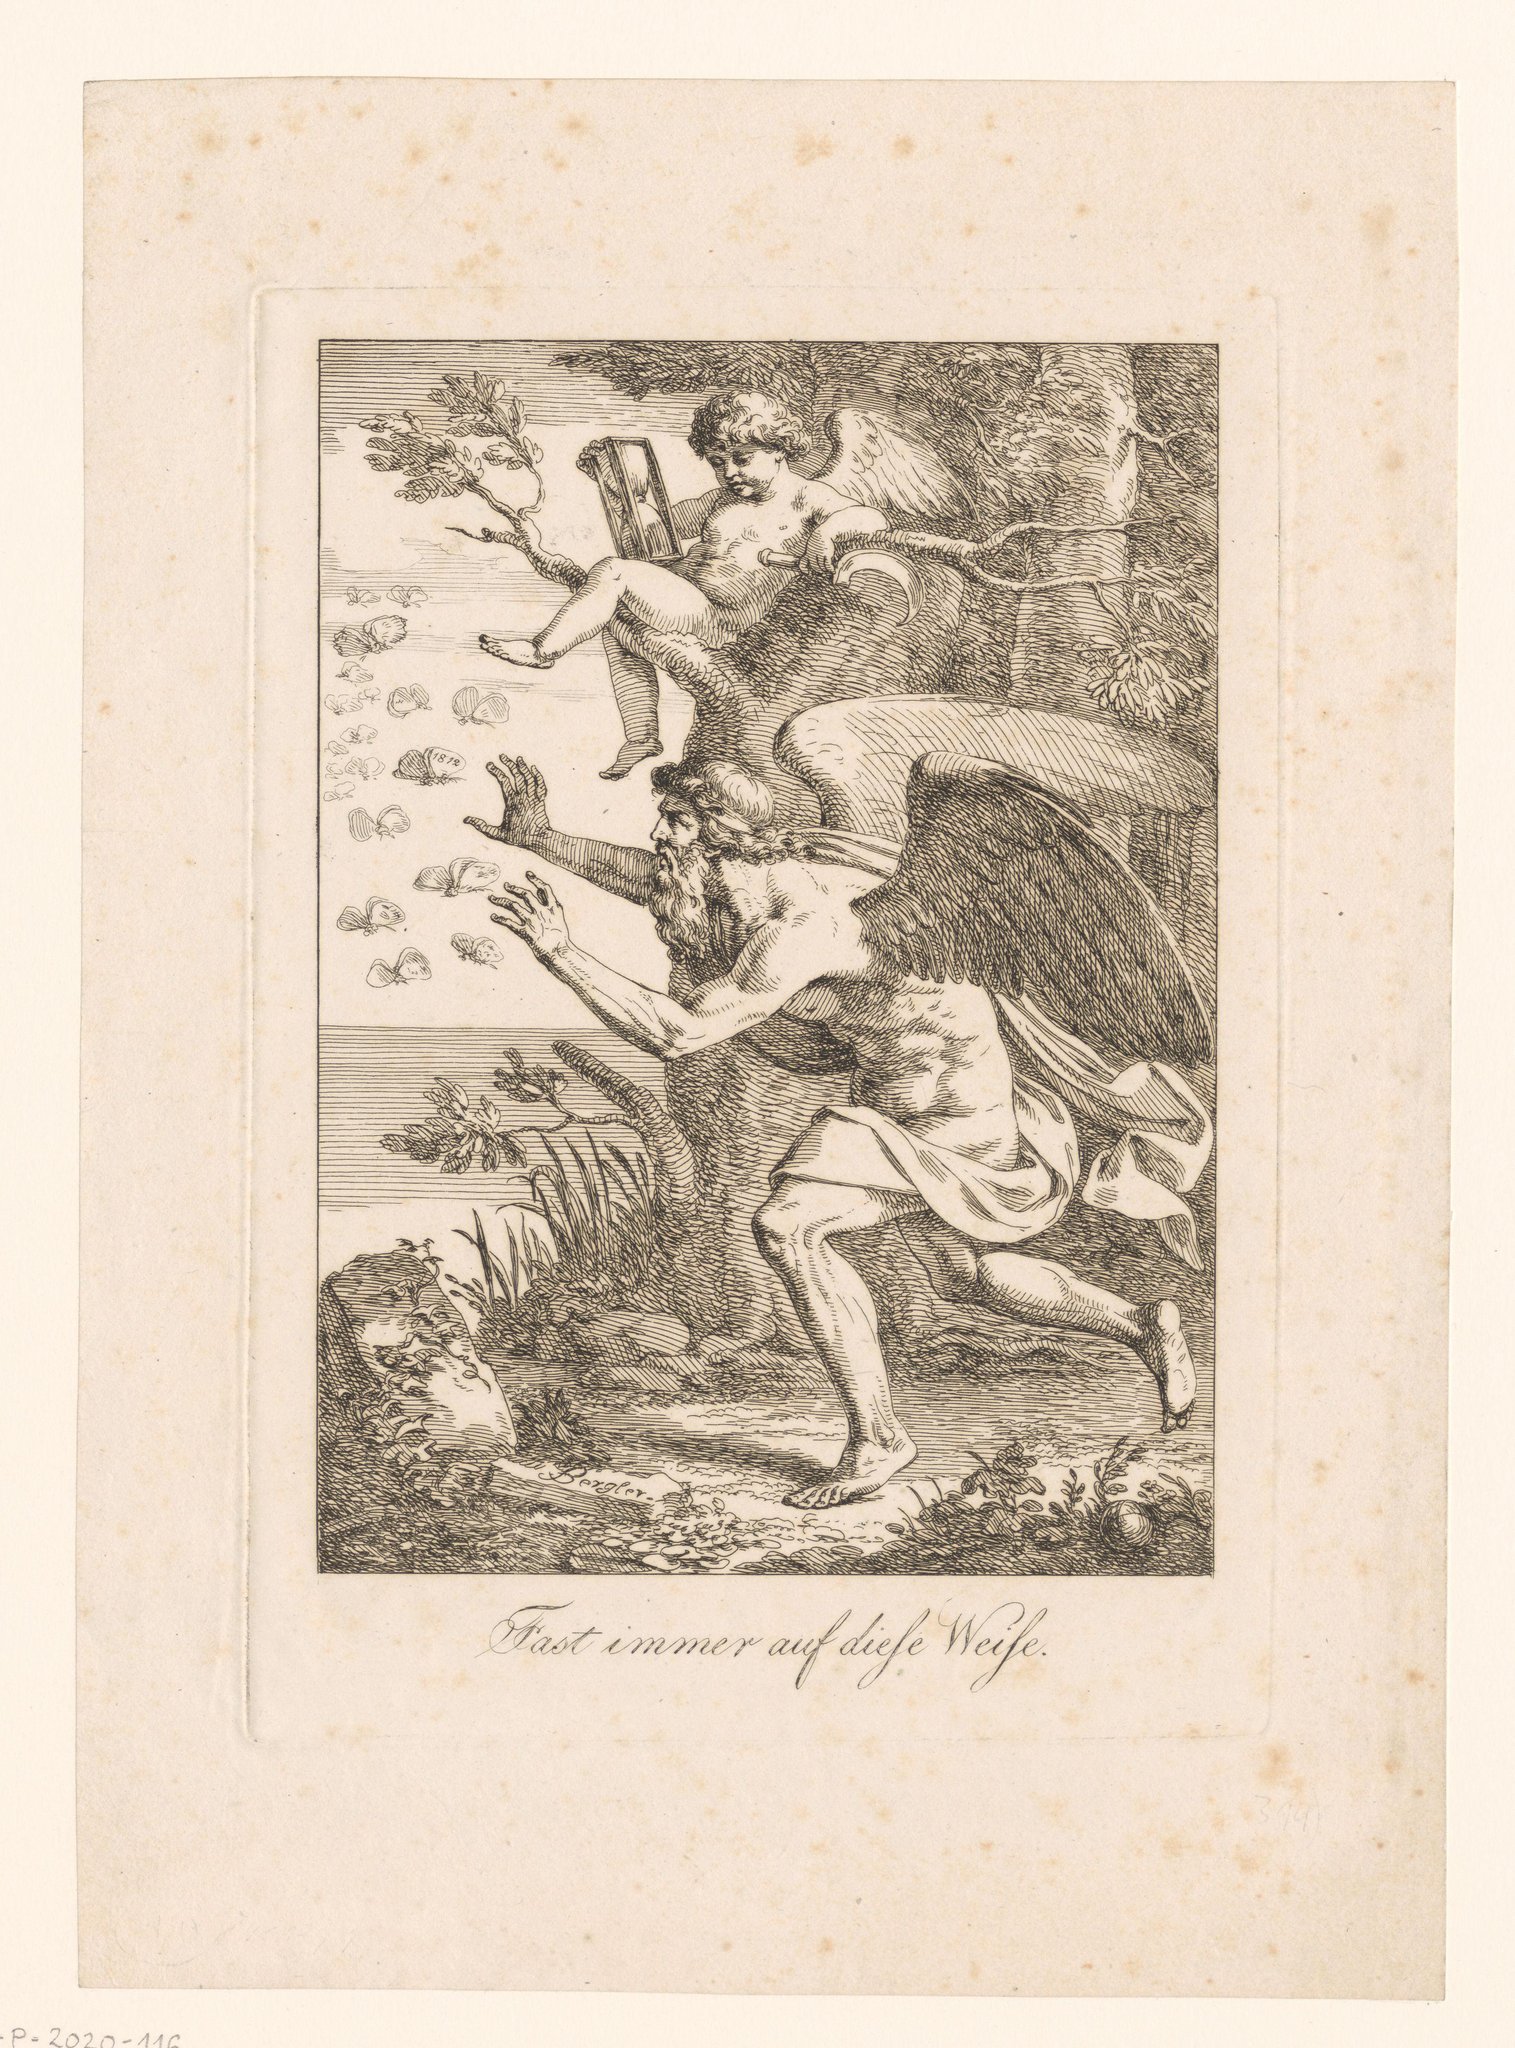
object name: print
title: Fast immer auf diese Weise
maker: joseph bergler (ii)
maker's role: draughtsman, painter, print maker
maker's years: 1753-1829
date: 1812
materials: paper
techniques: etching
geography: prague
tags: scenes symbolizing 'vanitas', fugacity of time, hourglass, hunting butterflies, insects: butterfly, father time, man with wings and scythe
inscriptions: collector's mark: Lugt 2760, collector's mark: Lugt 2228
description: De gevleugelde personificatie van de Tijd rent achter vlinders aan en probeert deze te vangen. Een vlinder draagt het jaartal 1812 op haar vleugel. Boven de Tijd in een boom zit een putto met een sikkel en een zandloper.